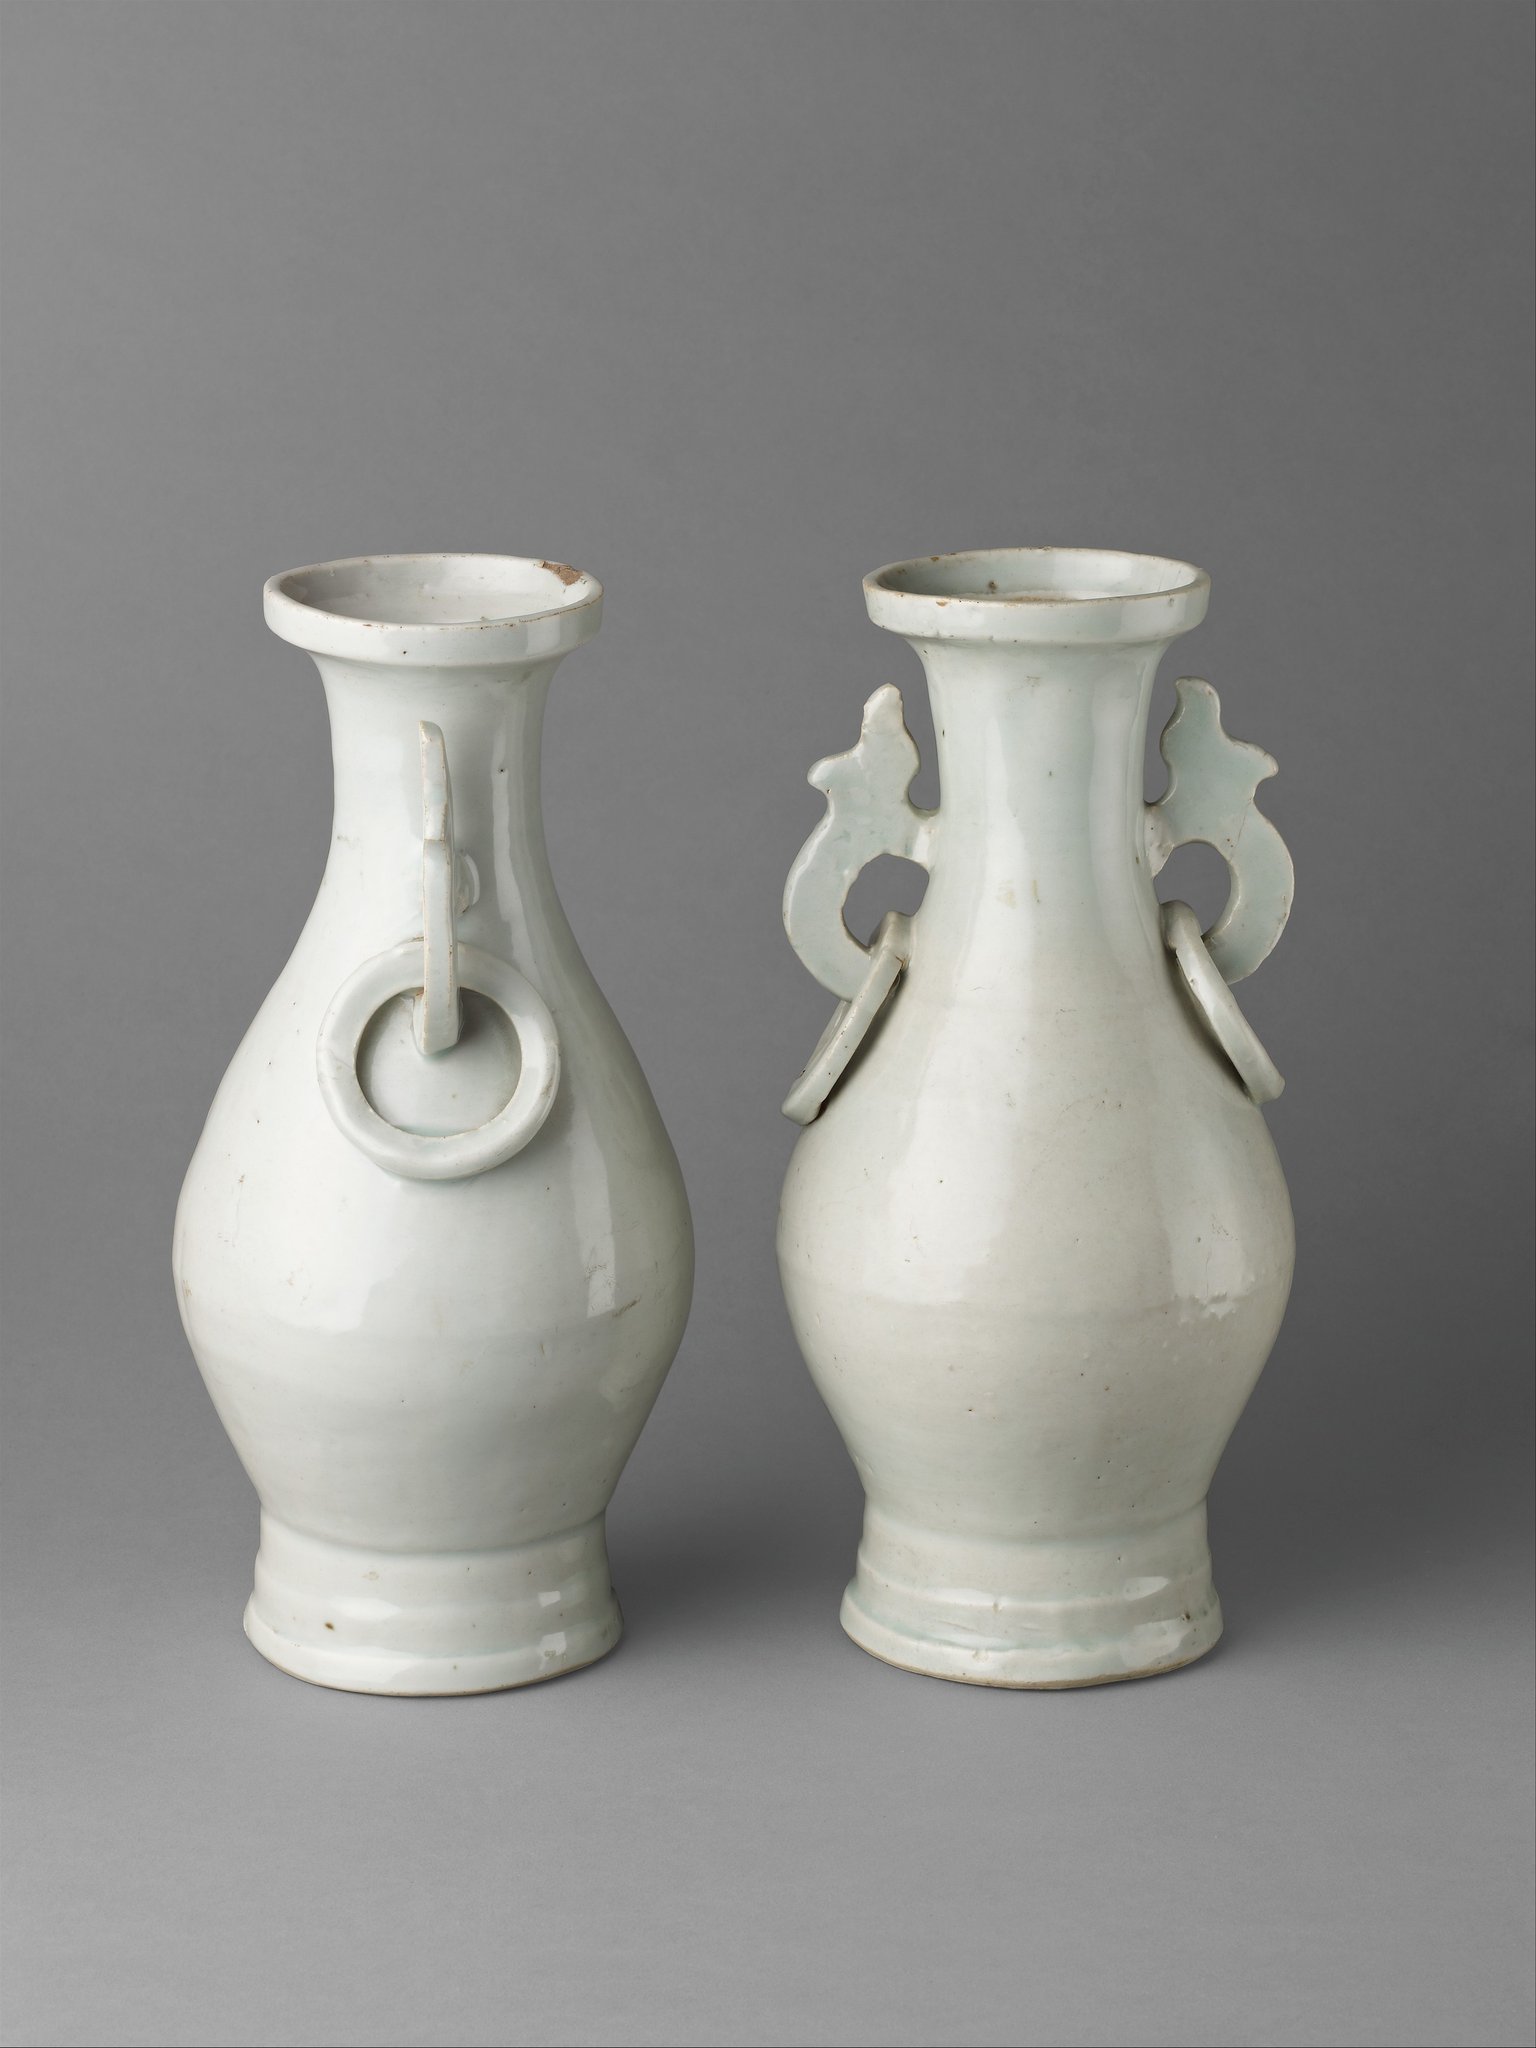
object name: vase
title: Vase: Qingbai Shufu-type ware (pair with 1975.1.1669)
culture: chinese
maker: chinese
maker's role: artist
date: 1301-1400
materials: glaze, porcelain